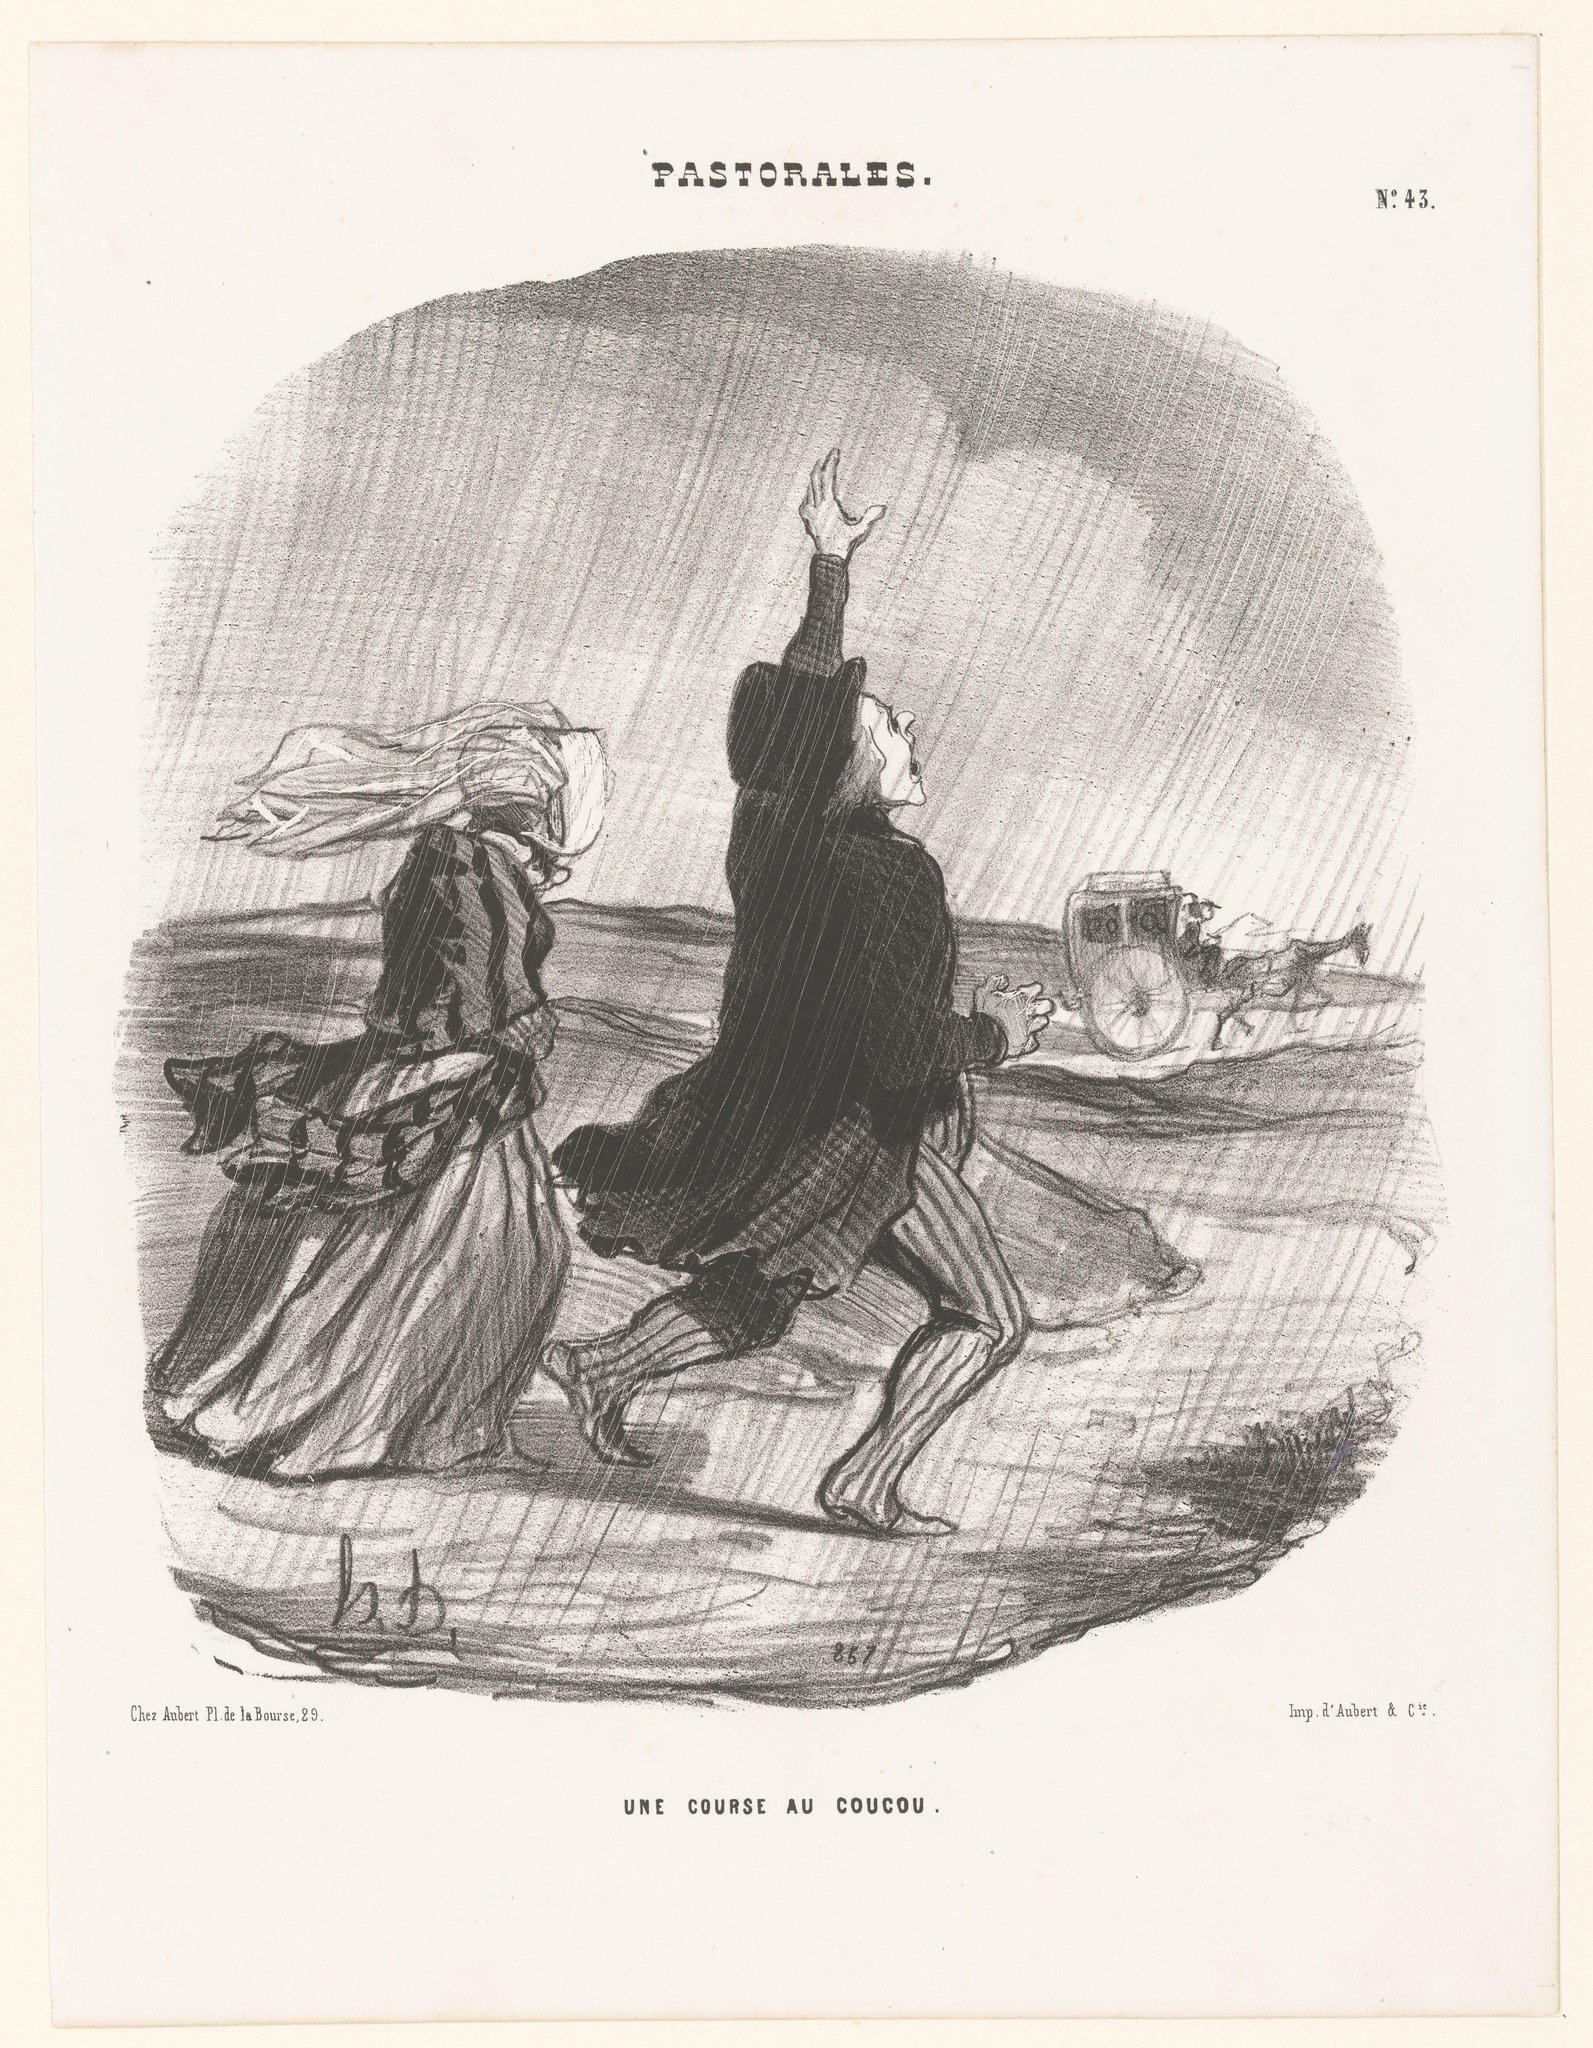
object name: cartoon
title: Pastorales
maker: honoré daumier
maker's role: draughtsman, painter, print maker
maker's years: 1808-1879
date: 1846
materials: paper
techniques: lithograph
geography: paris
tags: diligence, omnibus, horse-tram, caricatures (human types), rain, 'en route', traveller under way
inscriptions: collector's mark: Lugt 2228a